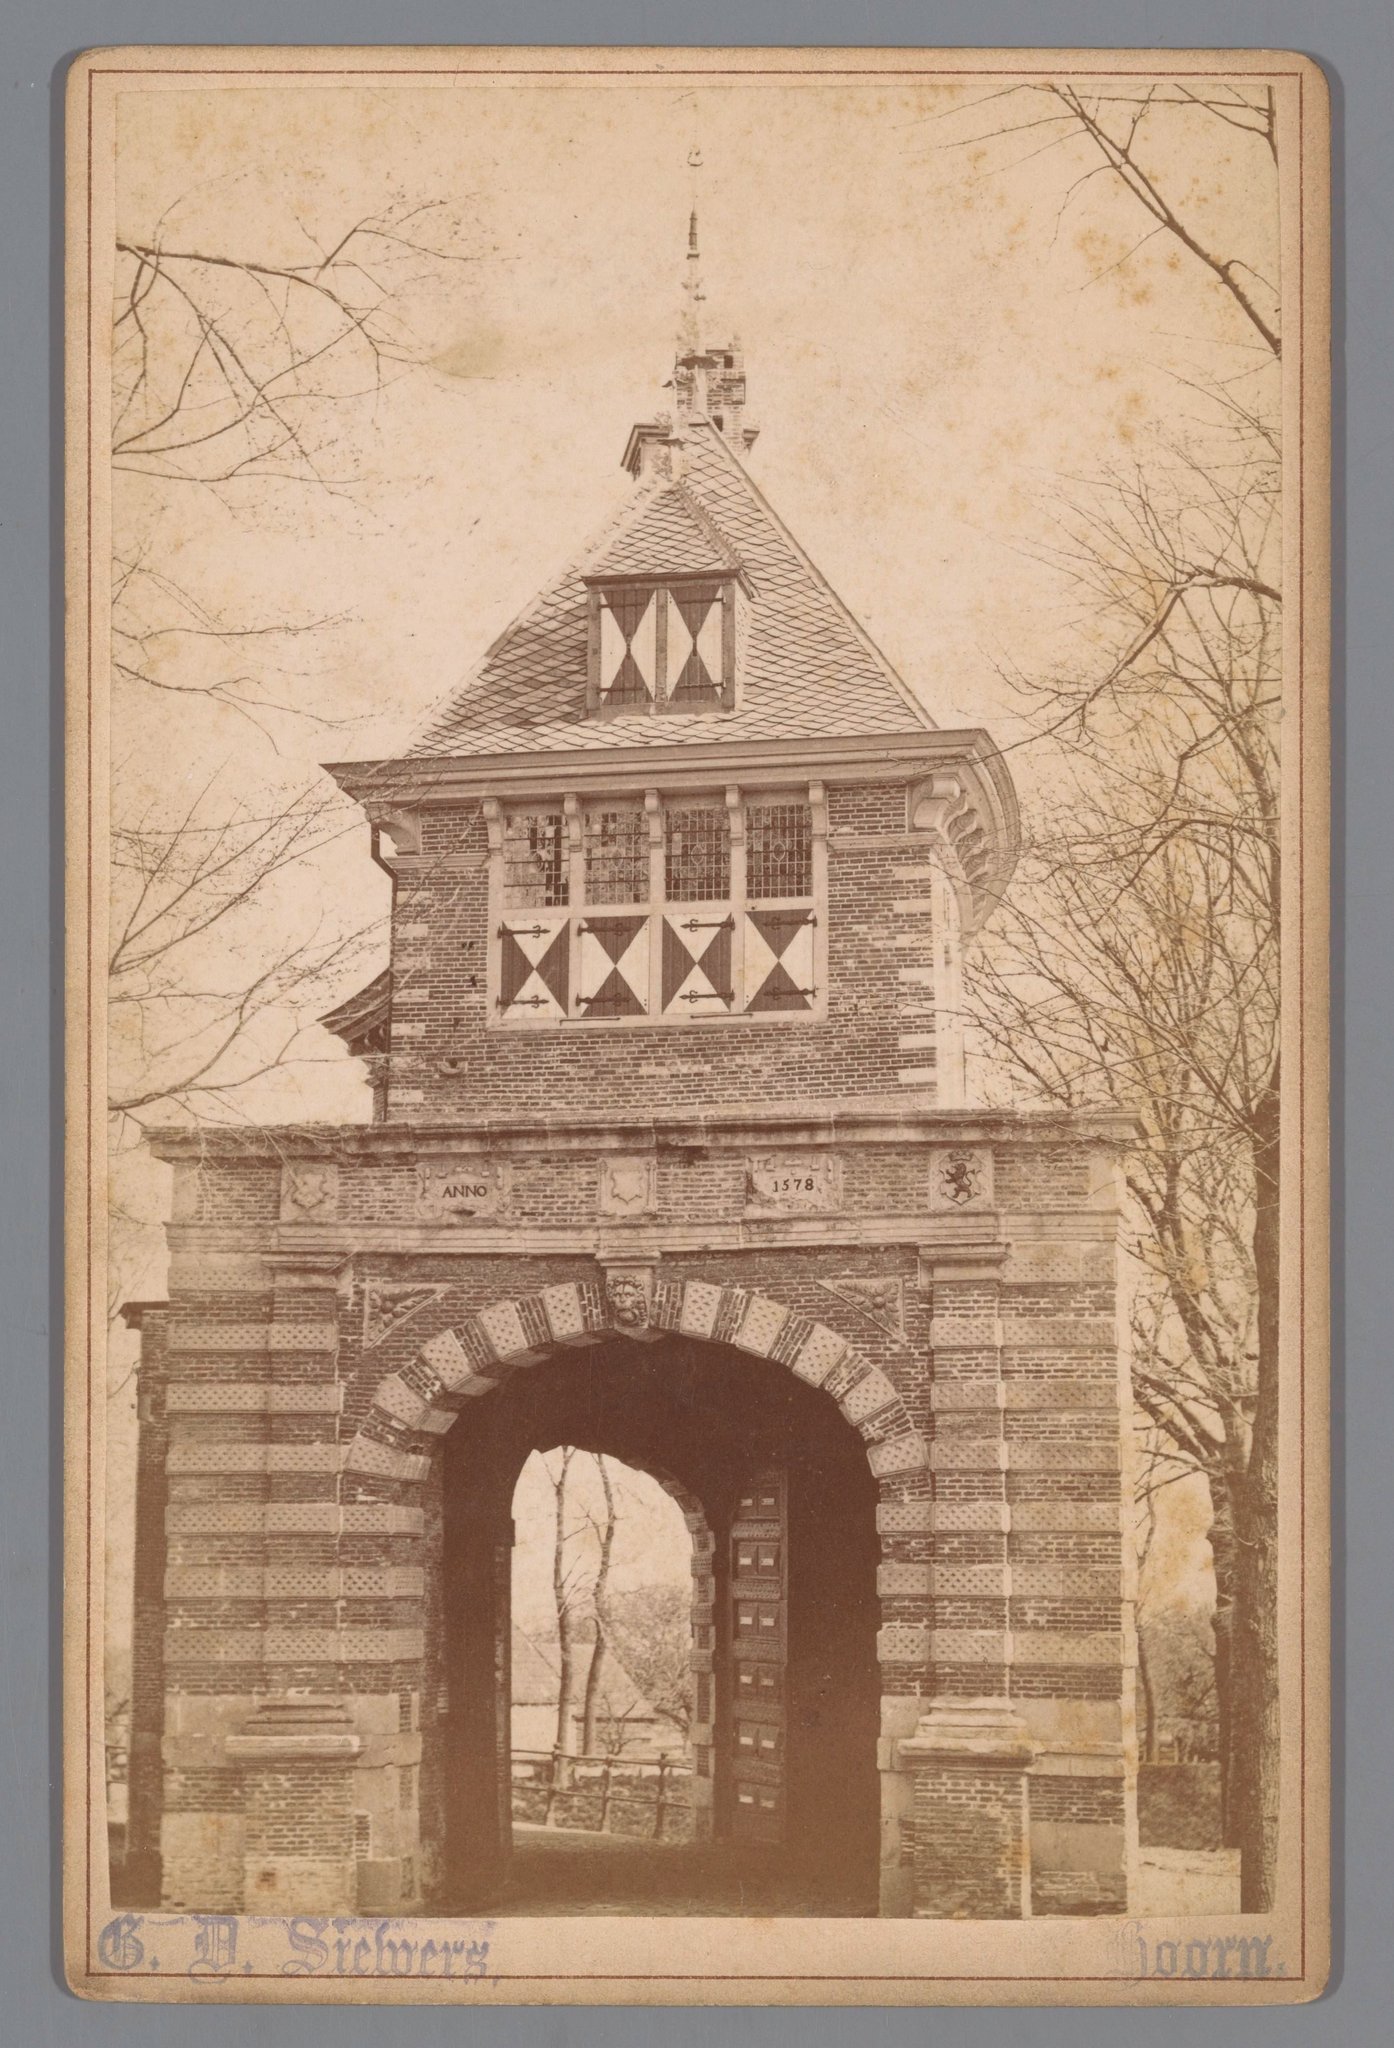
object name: cabinet photograph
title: Oosterpoort te Hoorn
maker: gerrit dirk siewers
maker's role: fotograaf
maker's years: 1846-1899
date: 1855-1890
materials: cardboard, photographic support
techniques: albumen print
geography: hoorn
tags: fence, wall, paling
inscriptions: name: ‘G.D. Siewers, Hoorn’